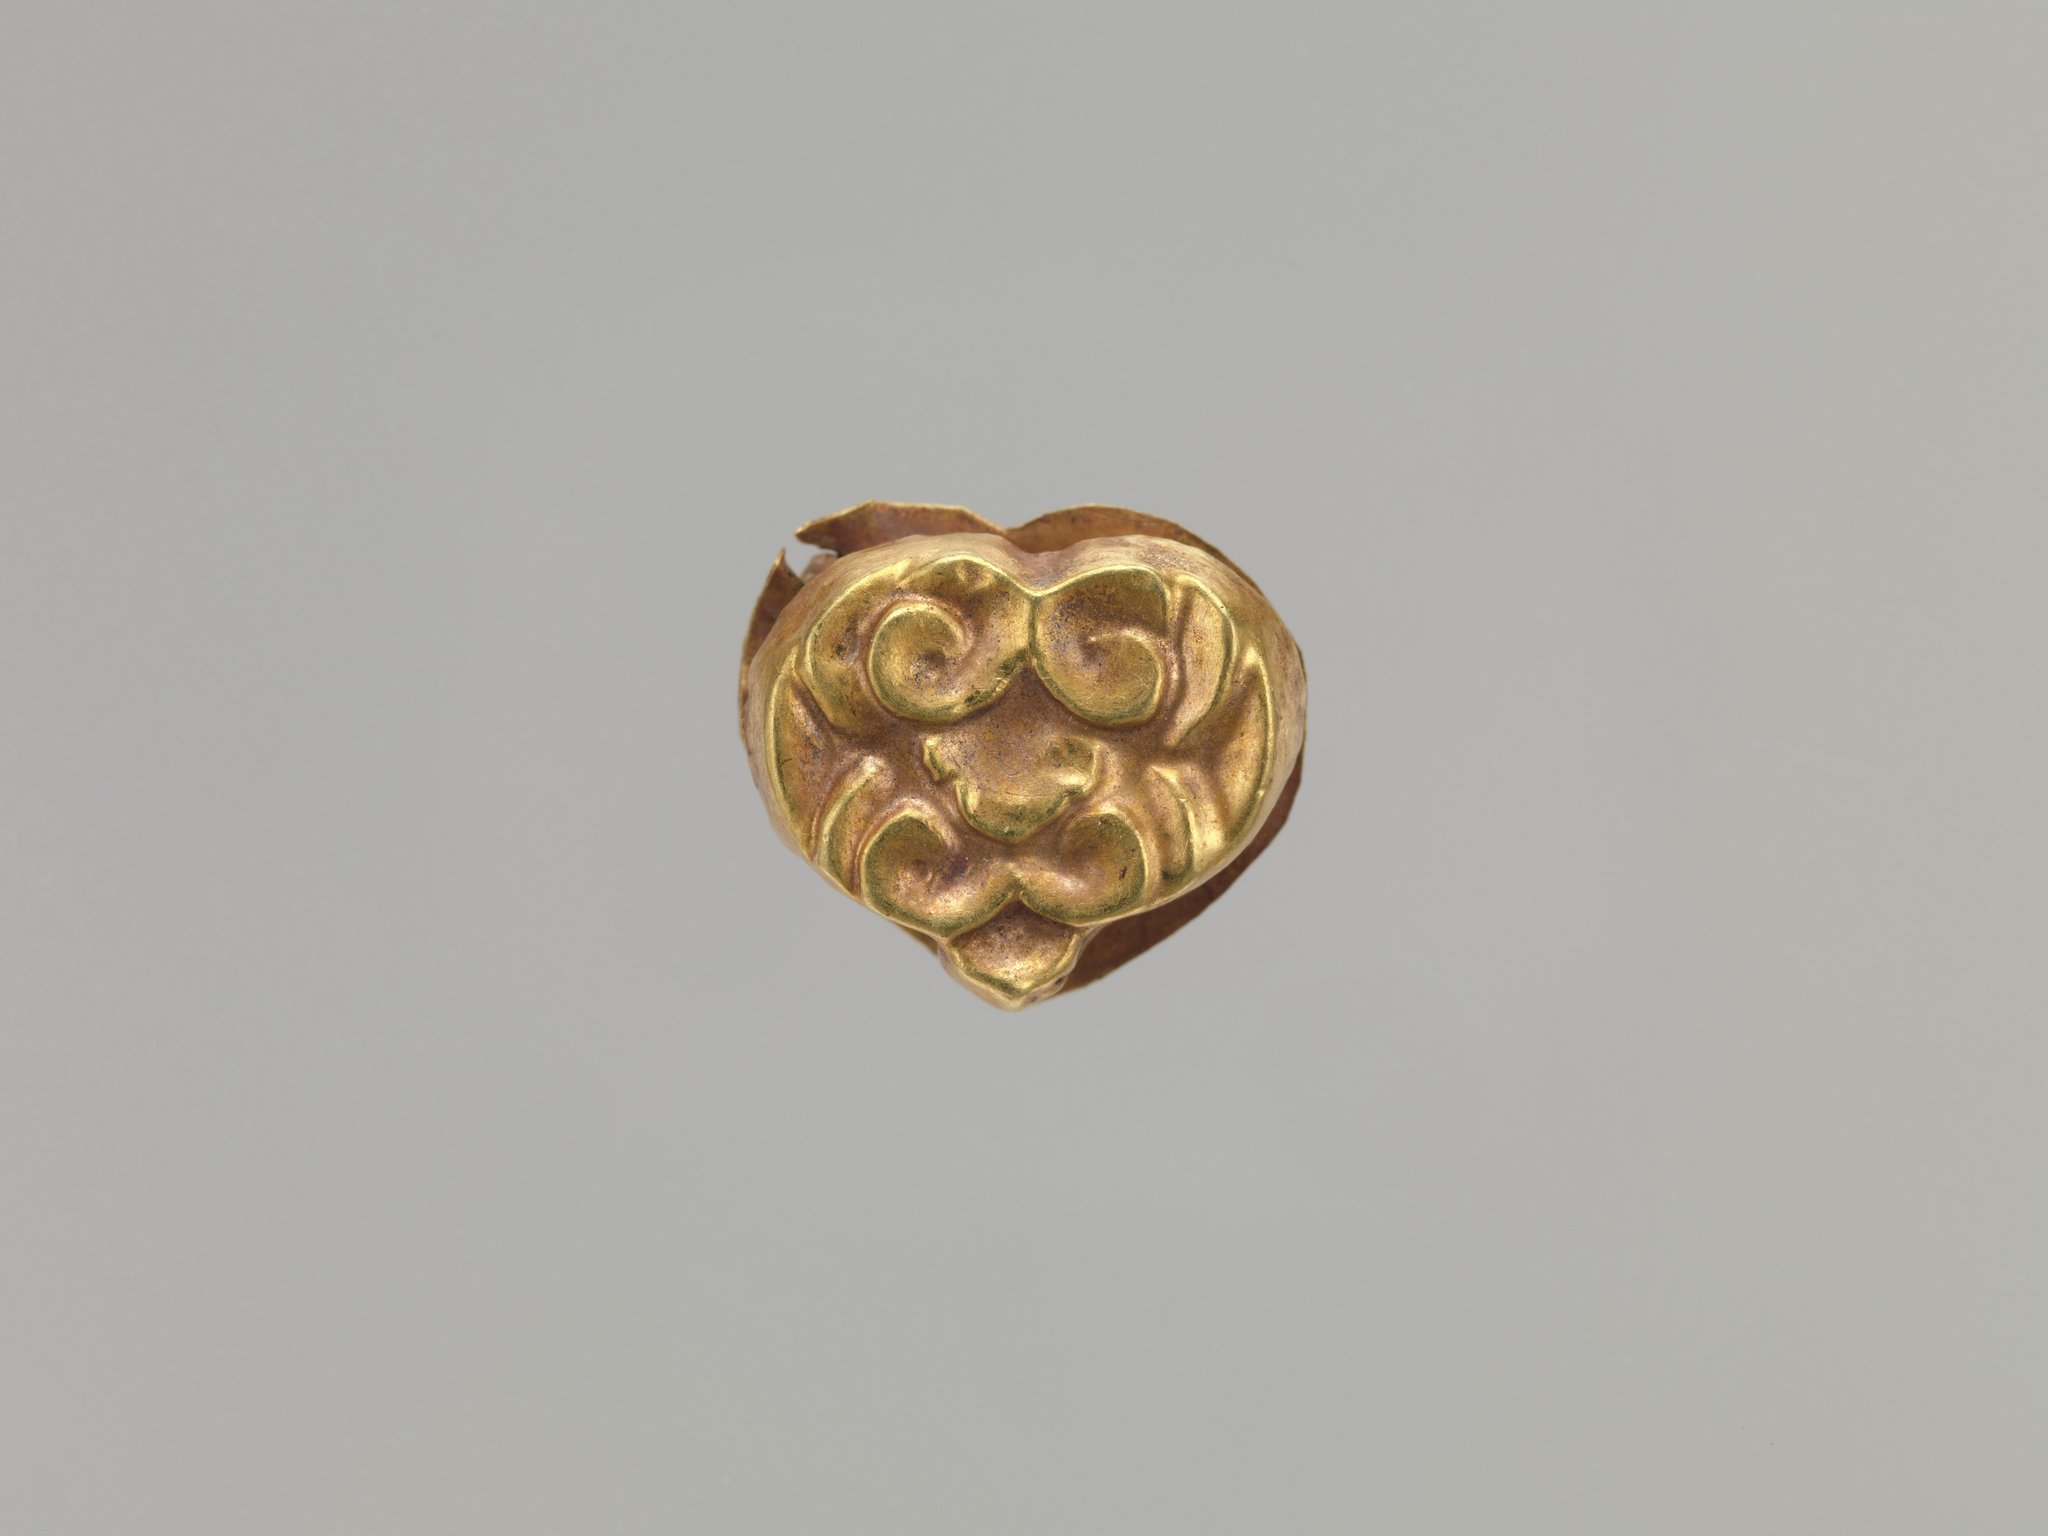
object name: attachment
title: Heart-Shaped Plaque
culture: chinese or central asian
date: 601-900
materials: gold